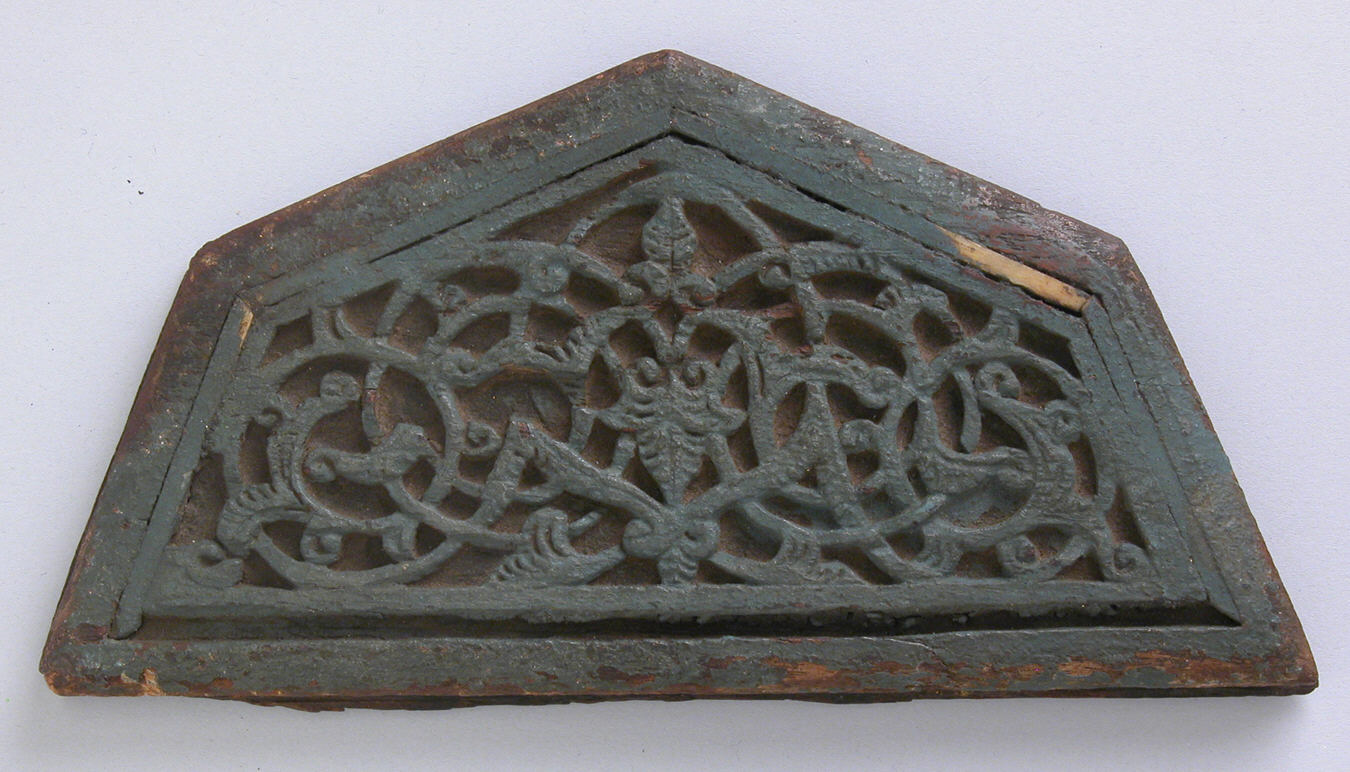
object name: panel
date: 1201-1400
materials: ivory, wood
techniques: carving, inlay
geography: egypt